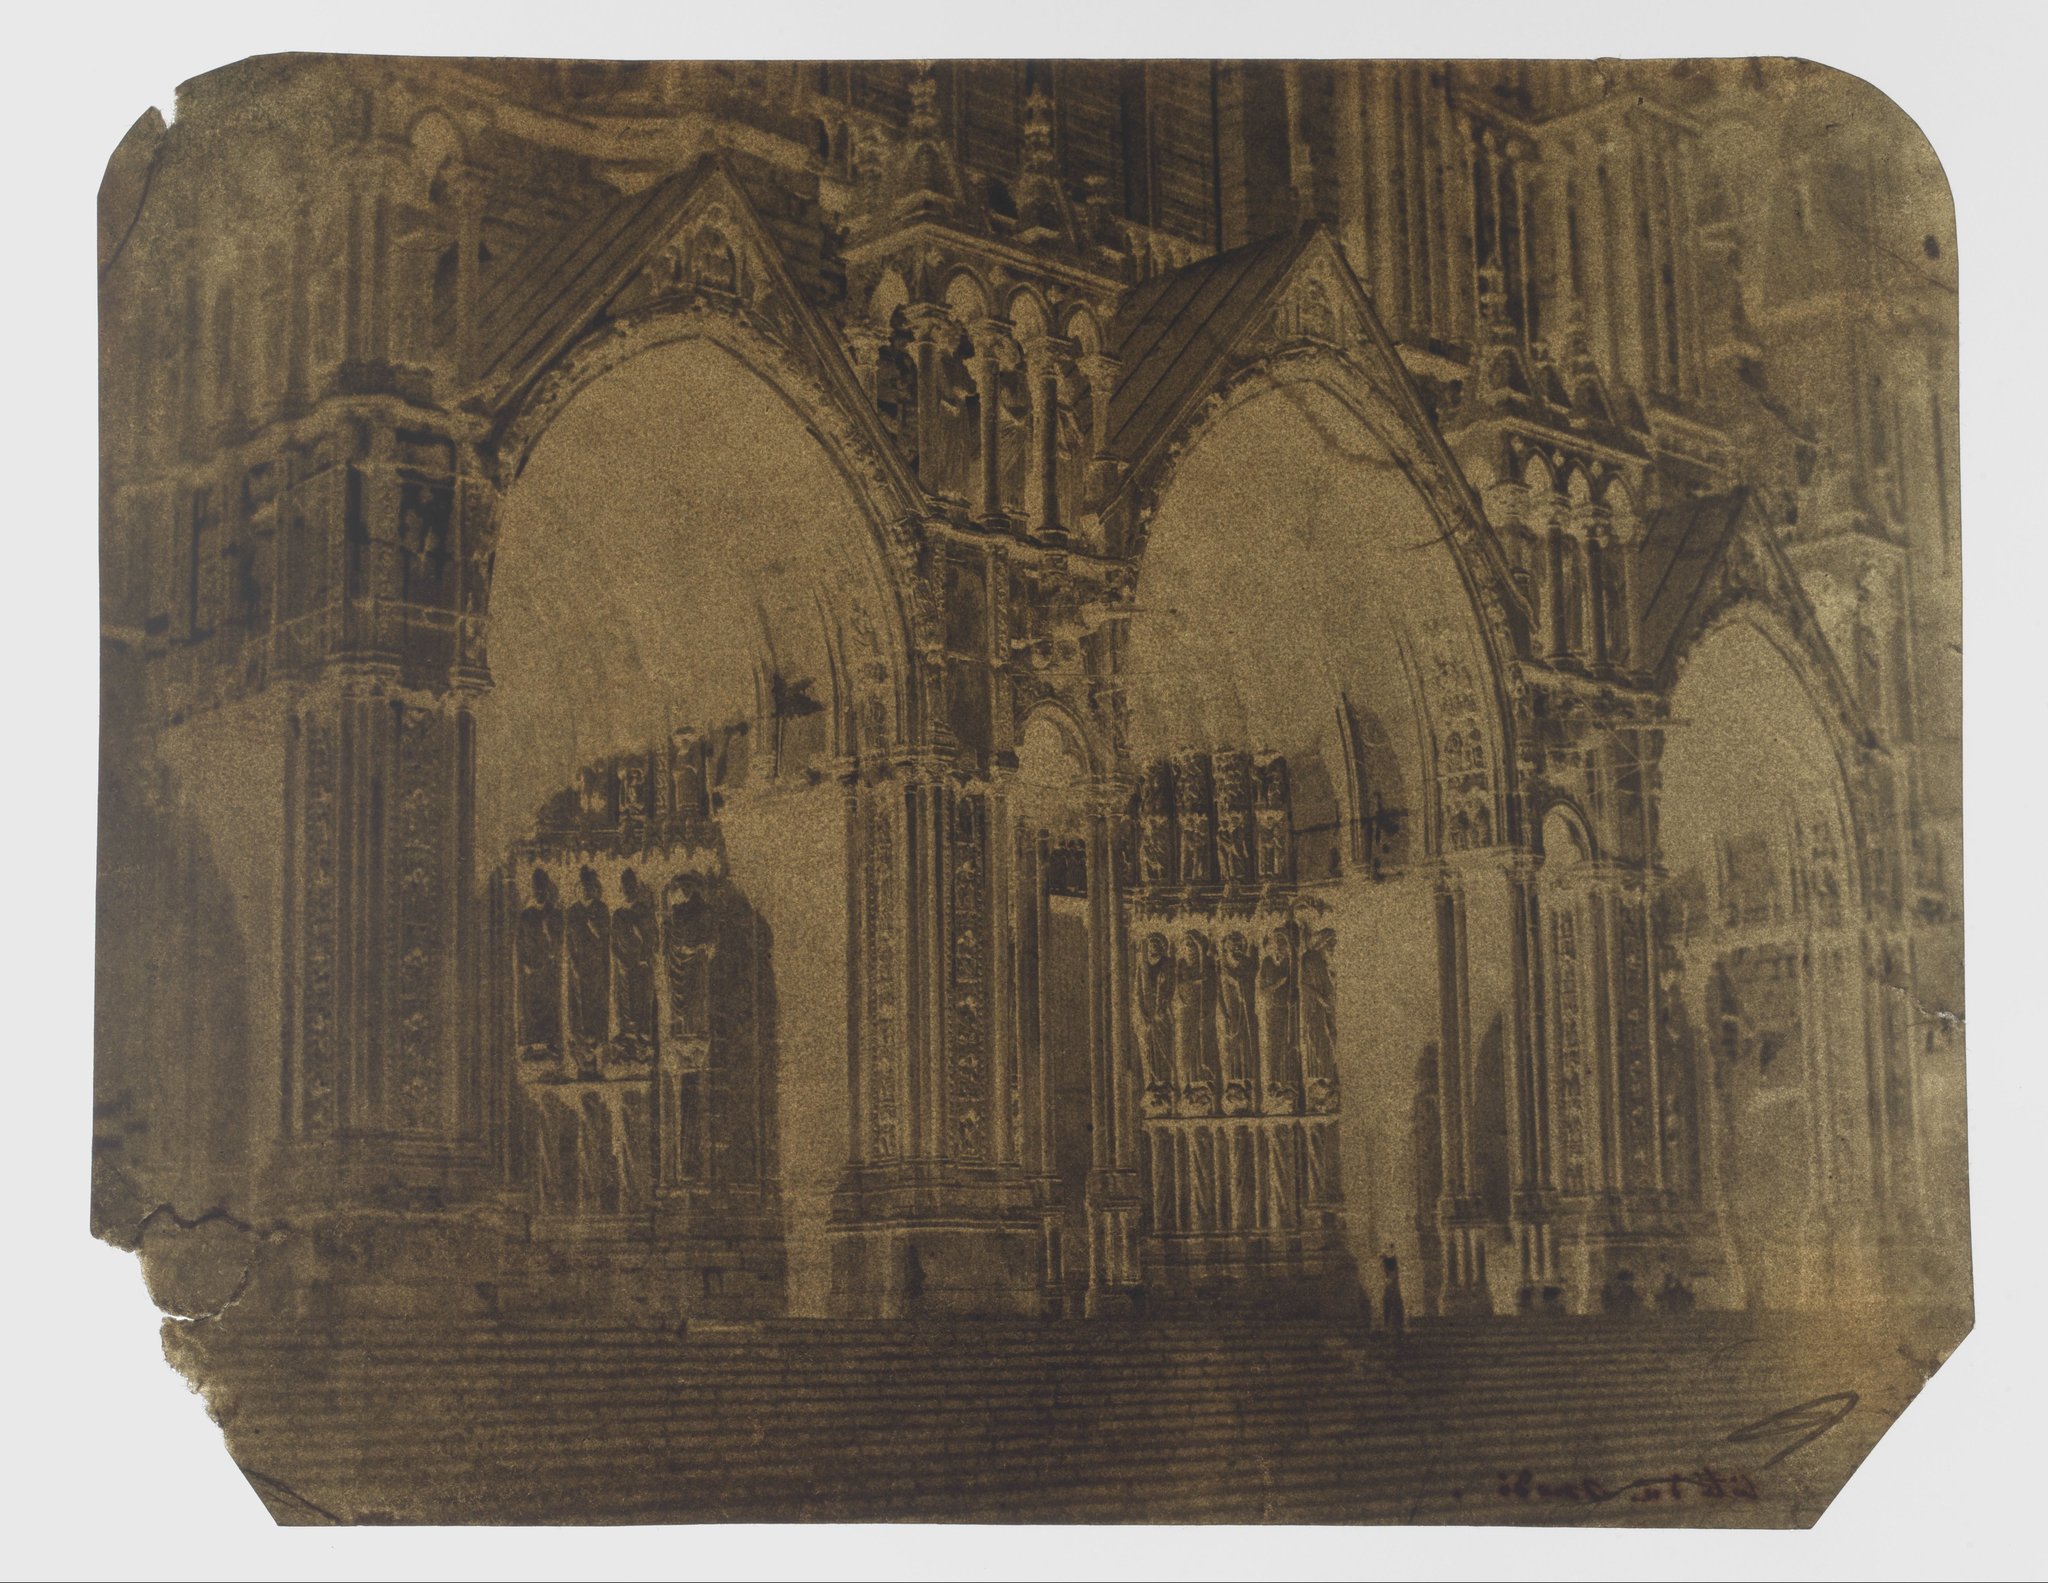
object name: papiernegatief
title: Portaal aan de zuidzijde van de kathedraal van Chartres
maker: charles nègre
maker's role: fotograaf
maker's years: 1820-1880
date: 1854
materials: paper, wax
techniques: paper negative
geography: chartres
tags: parts of church exterior and annexes: portal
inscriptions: inscription: ‘Côté du Midi’